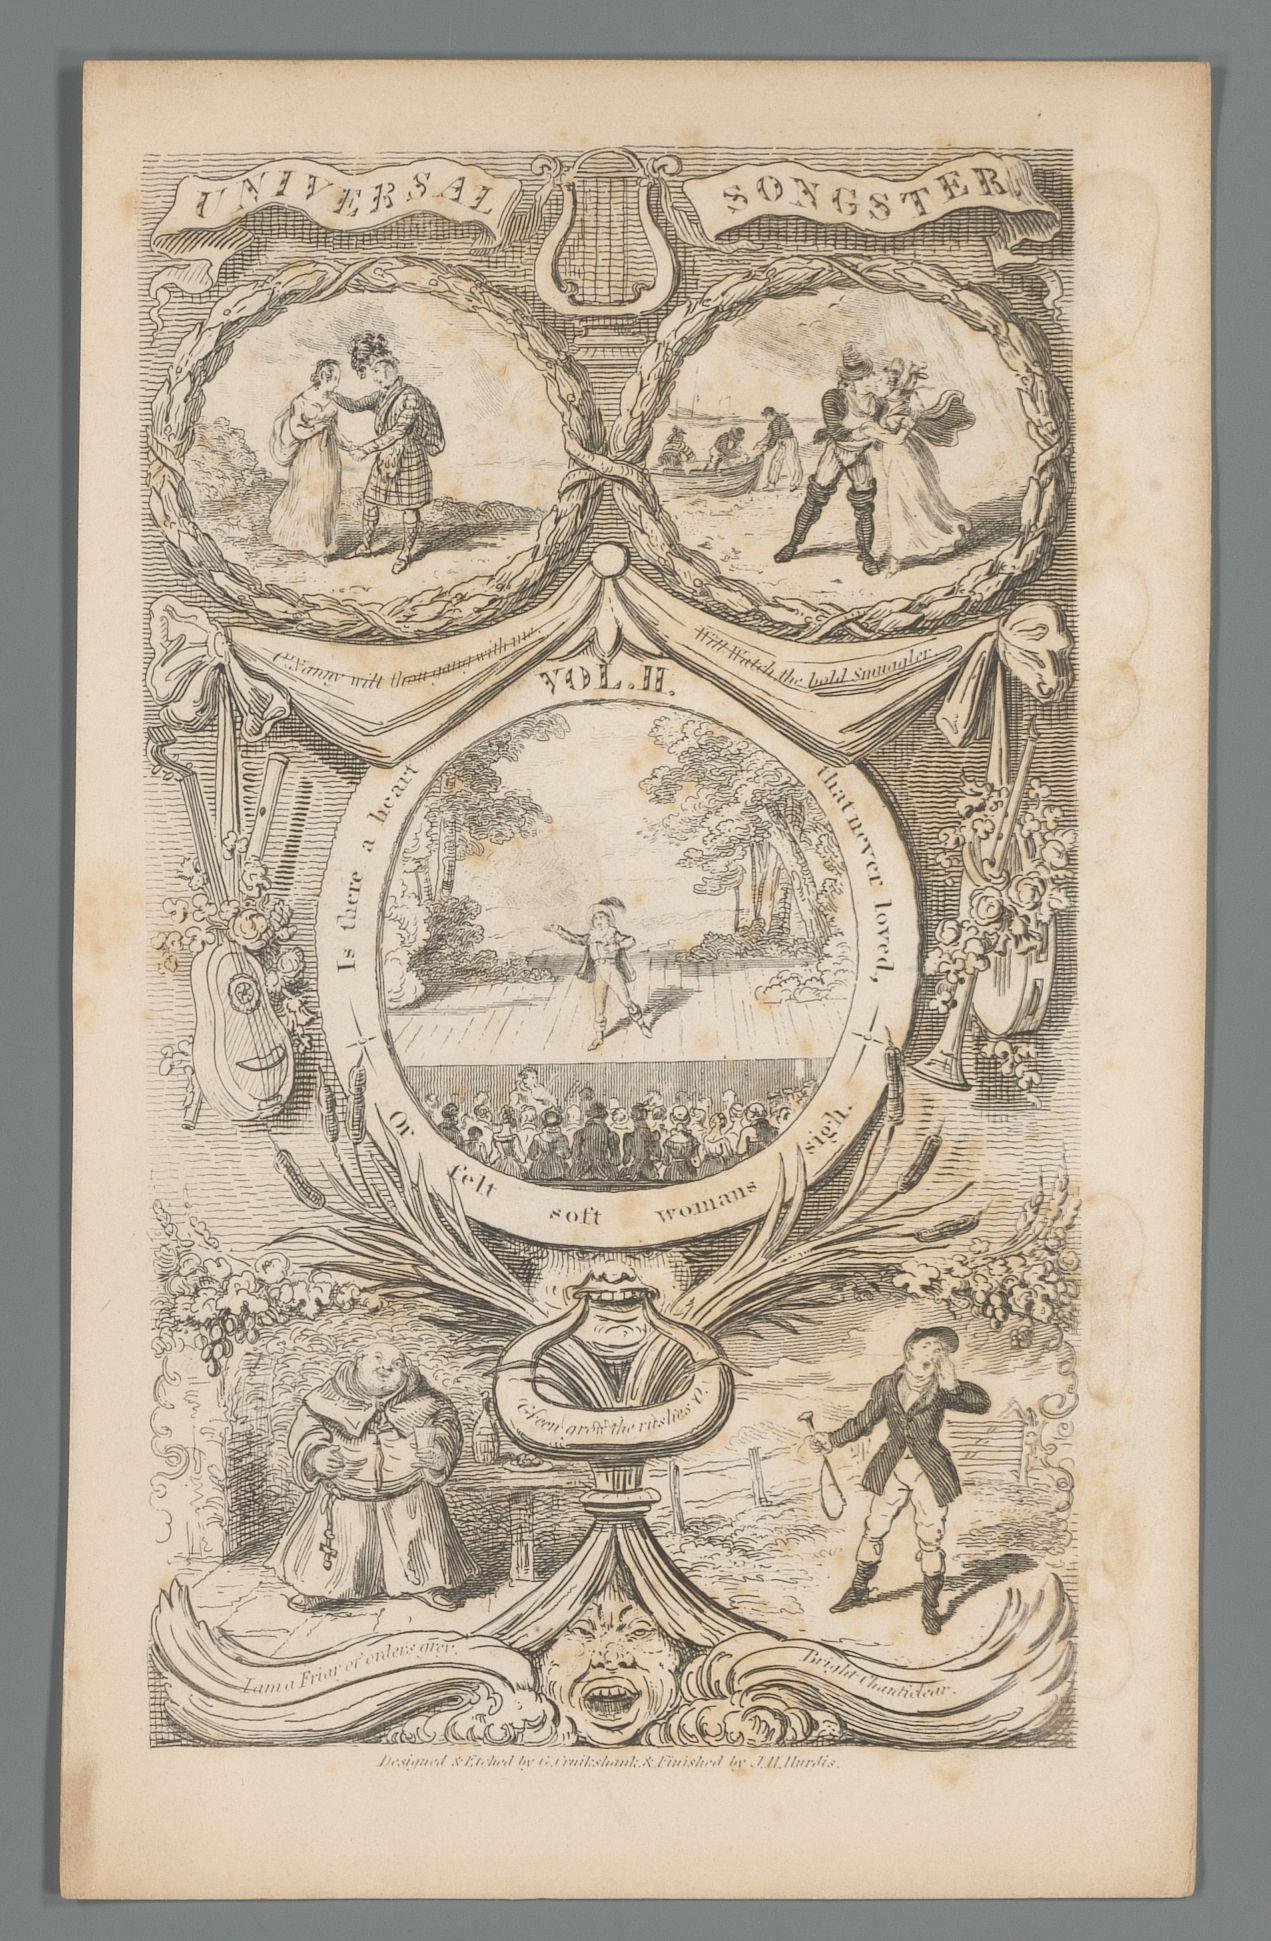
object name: cartoon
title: Frontispice voor: The Universal Songster, vol. II (1826)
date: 1826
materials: paper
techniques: etching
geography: england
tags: political caricatures and satires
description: Illustratie genomen uit een uitgave van: The Universal Songster, or Museum of Mirth: the most complete, extensive and valuable collection of ancient and modern songs in the English language, vol. II., John Fairburn: Londen, eerst verschenen in 1826.